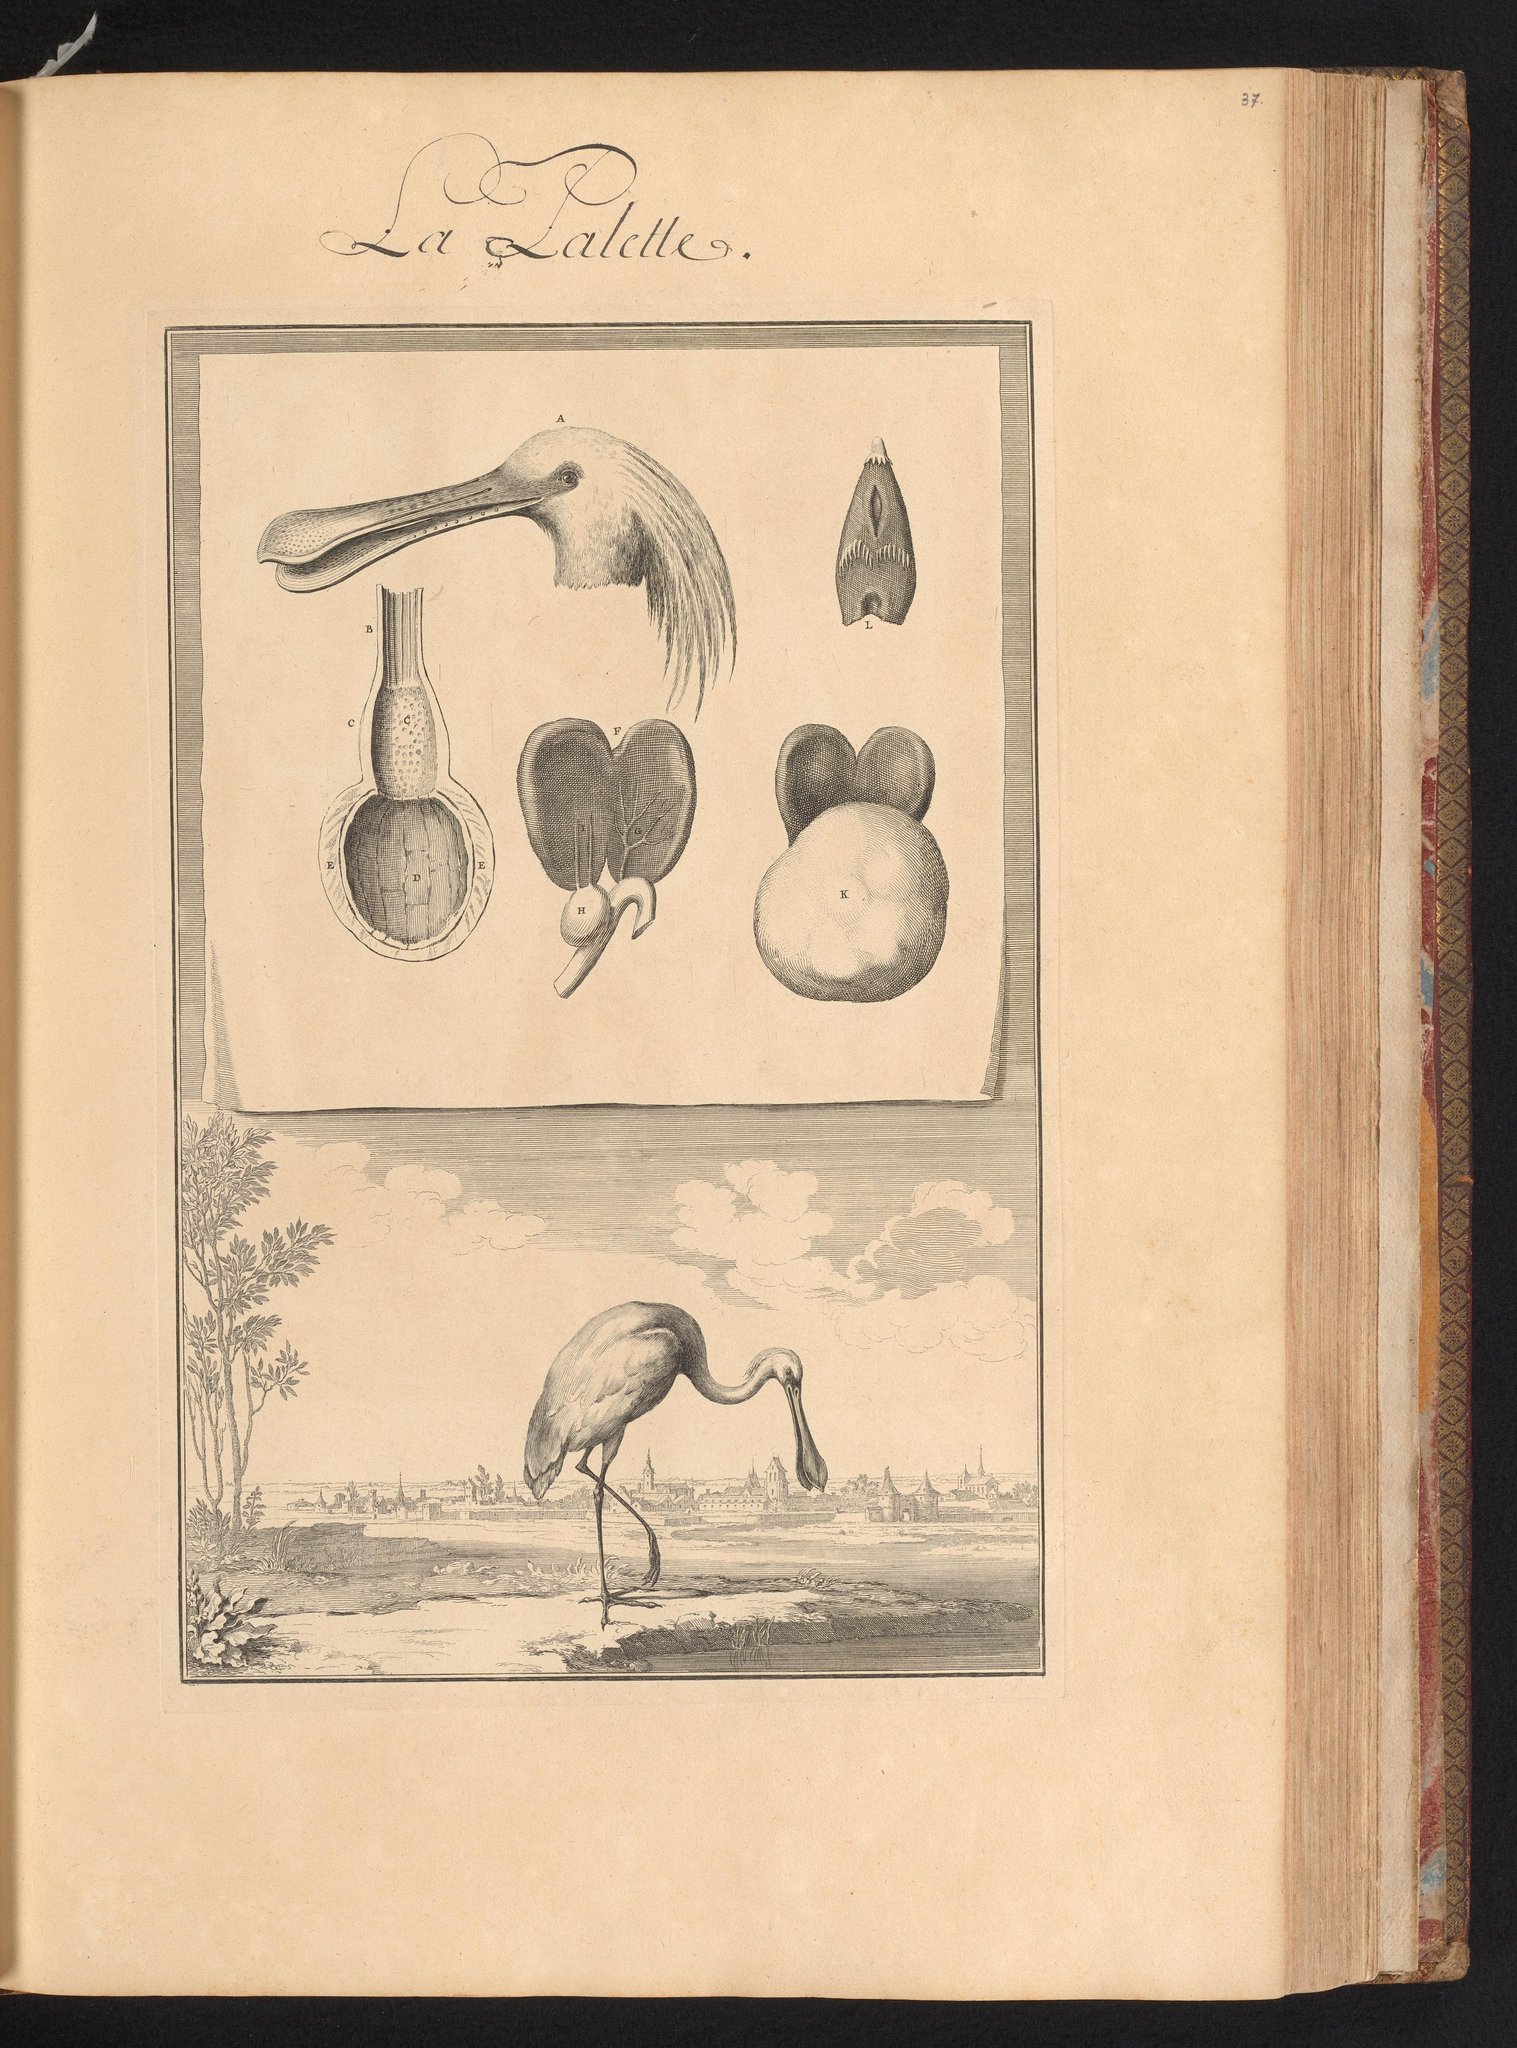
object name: print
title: Lepelaar (platalea leucorodia) in een landschap met bovenaan op een blad de organen van het dier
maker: sébastien leclerc (i)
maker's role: print maker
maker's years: 1637-1714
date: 1676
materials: ink, paper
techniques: engraving, etching, pen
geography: paris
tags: dissection, animals (+ anatomy of animals), shore-birds and wading-birds: spoonbill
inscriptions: inscription: ‘La Palette.’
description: Prent uit een editie van Claude Perraults 'Mémoires pour servir à l'histoire naturelle des animaux'.